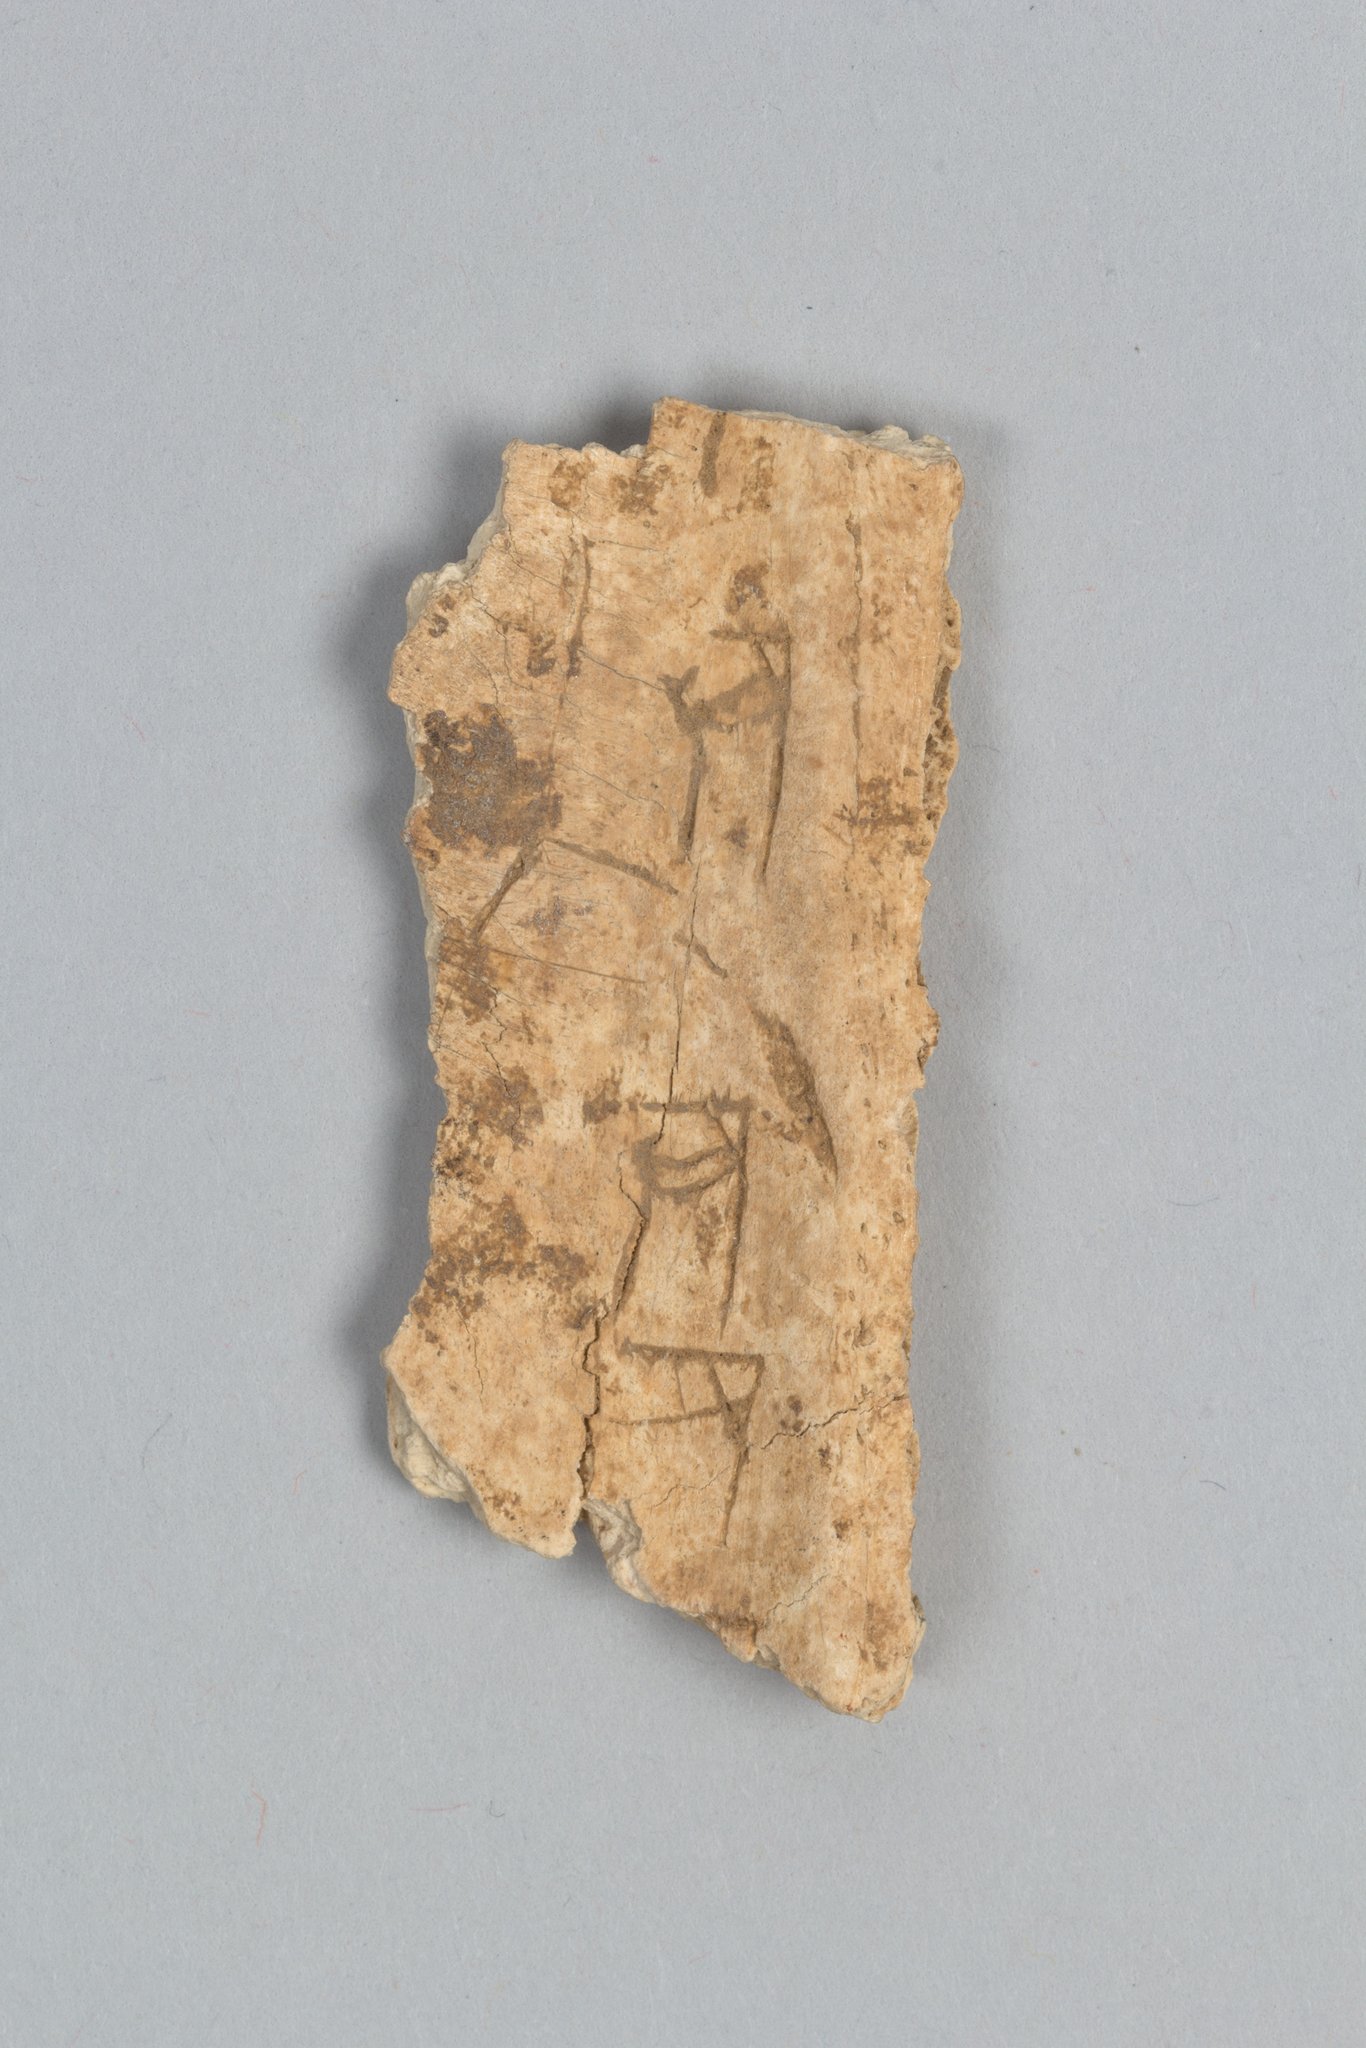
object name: oracle bone fragment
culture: chinese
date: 1610-1036 BCE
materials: bone